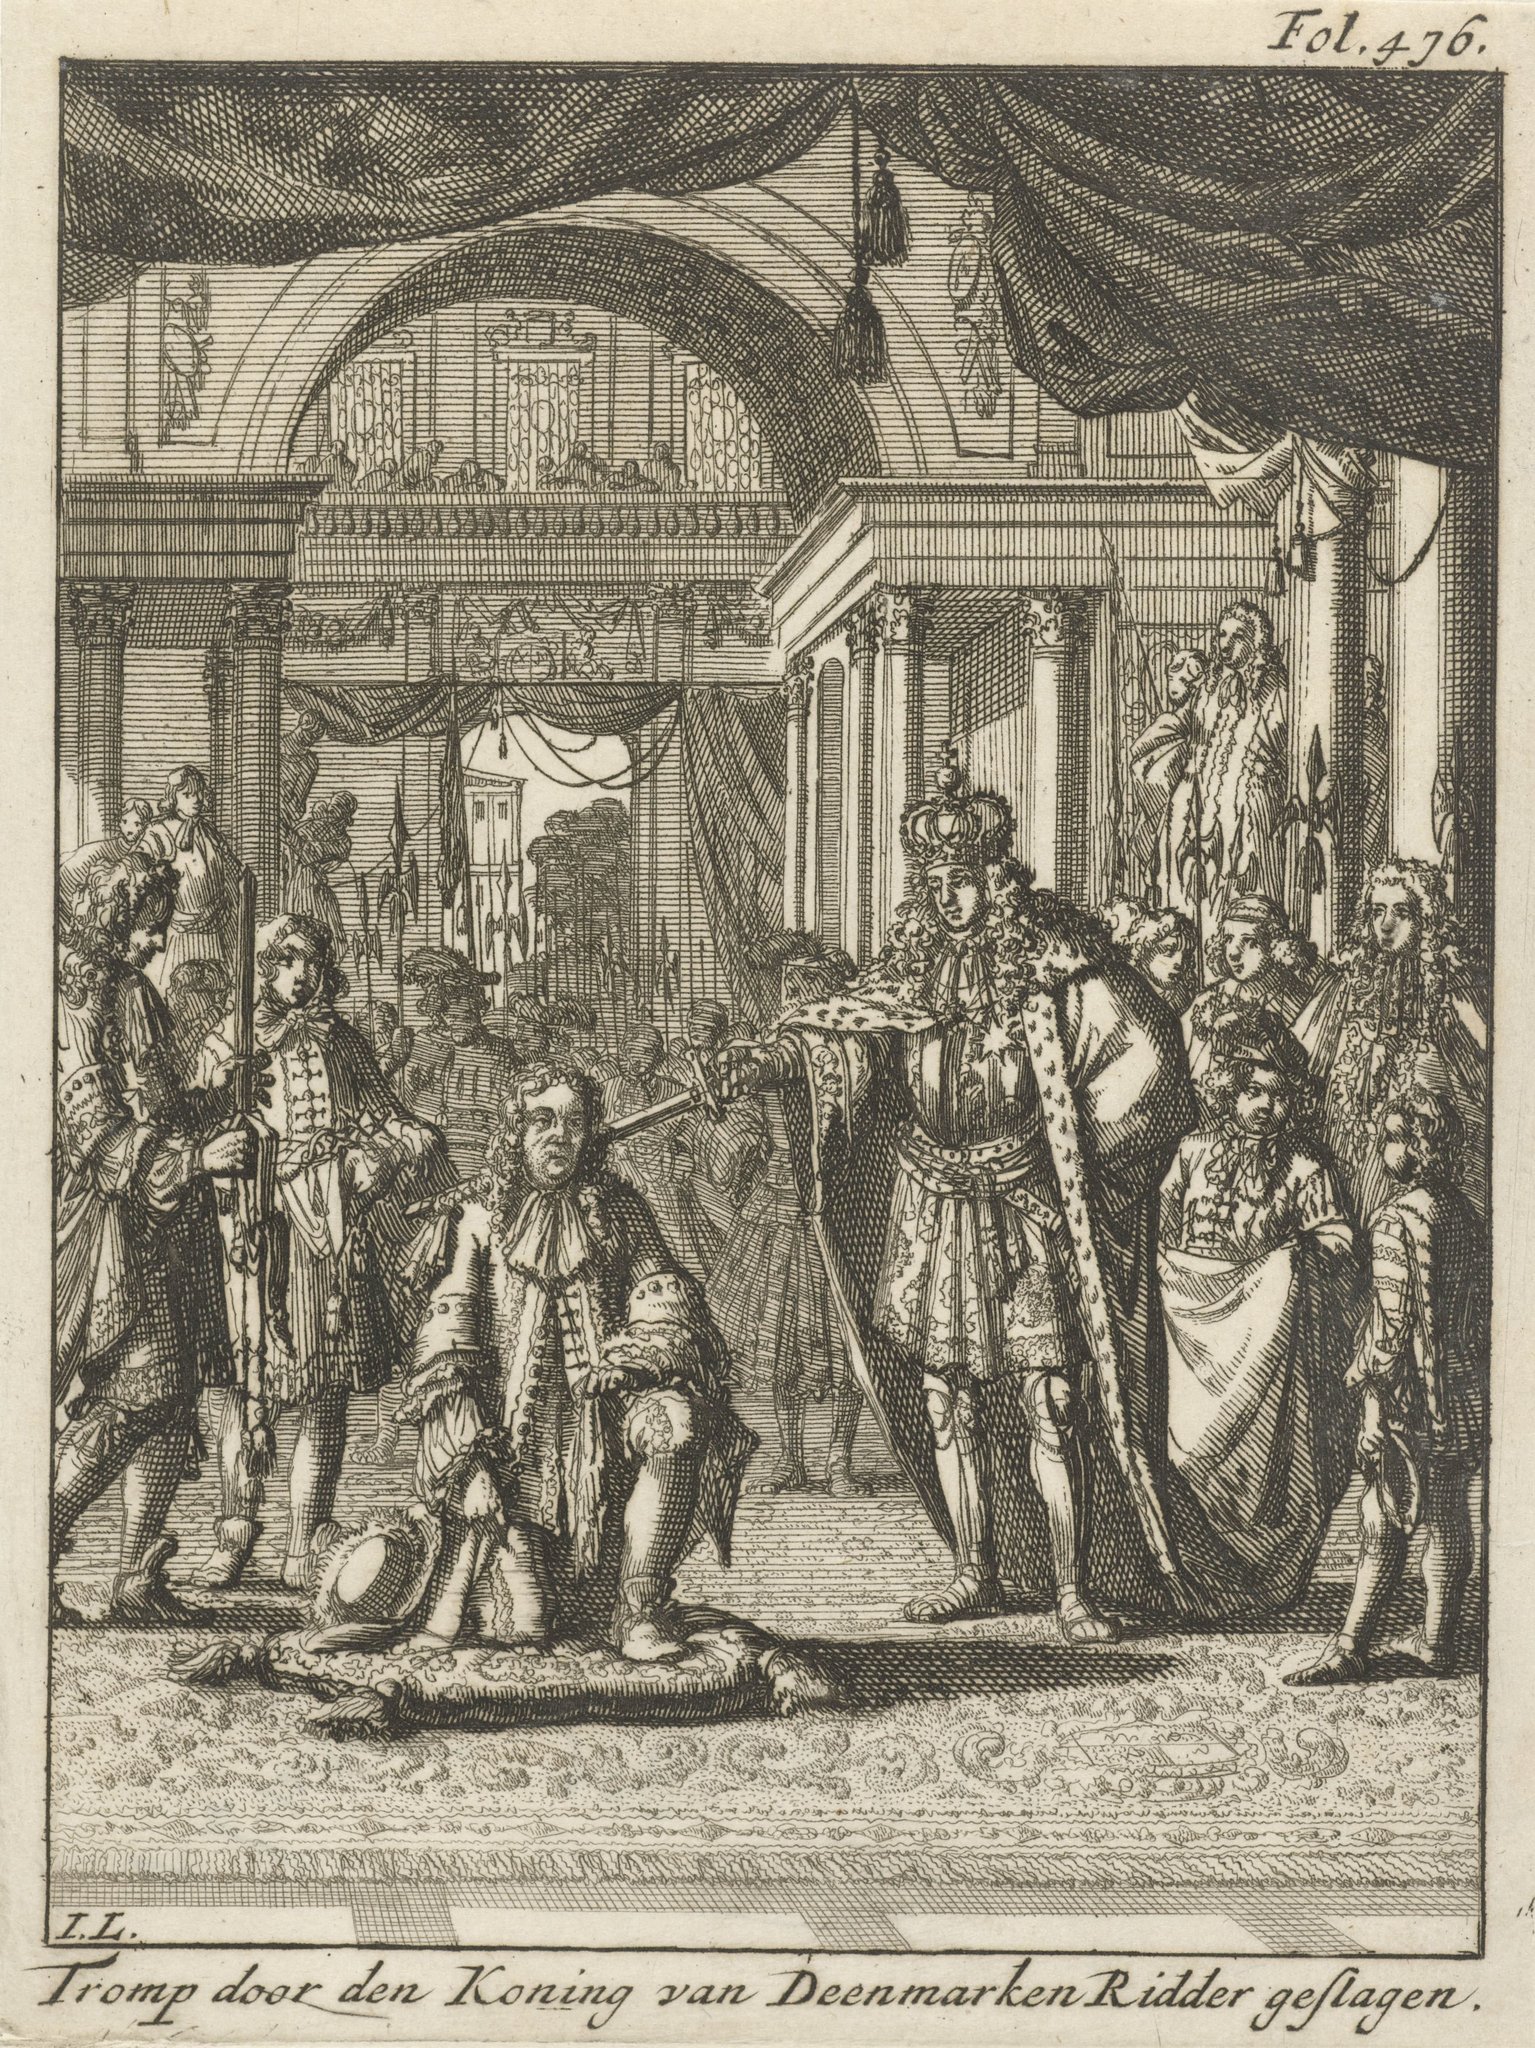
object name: print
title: Cornelis Tromp door de koning van Denemarken tot Ridder geslagen, 1676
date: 1692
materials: paper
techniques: etching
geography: haarlem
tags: cornelis tromp, knighting ceremonies, ruler bestowing nobility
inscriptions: collector's mark: Lugt 2228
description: Admiraal Cornelis Tromp wordt na de overwinning, behaald door de gecombineerde Hollands-Deense vloot op de Zweedse vloot in de slag bij Öland op 11 juni 1676, door de koning Christiaan V van Denemarken tot ridder geslagen. Prent rechtsboven gemerkt: Fol. 476.